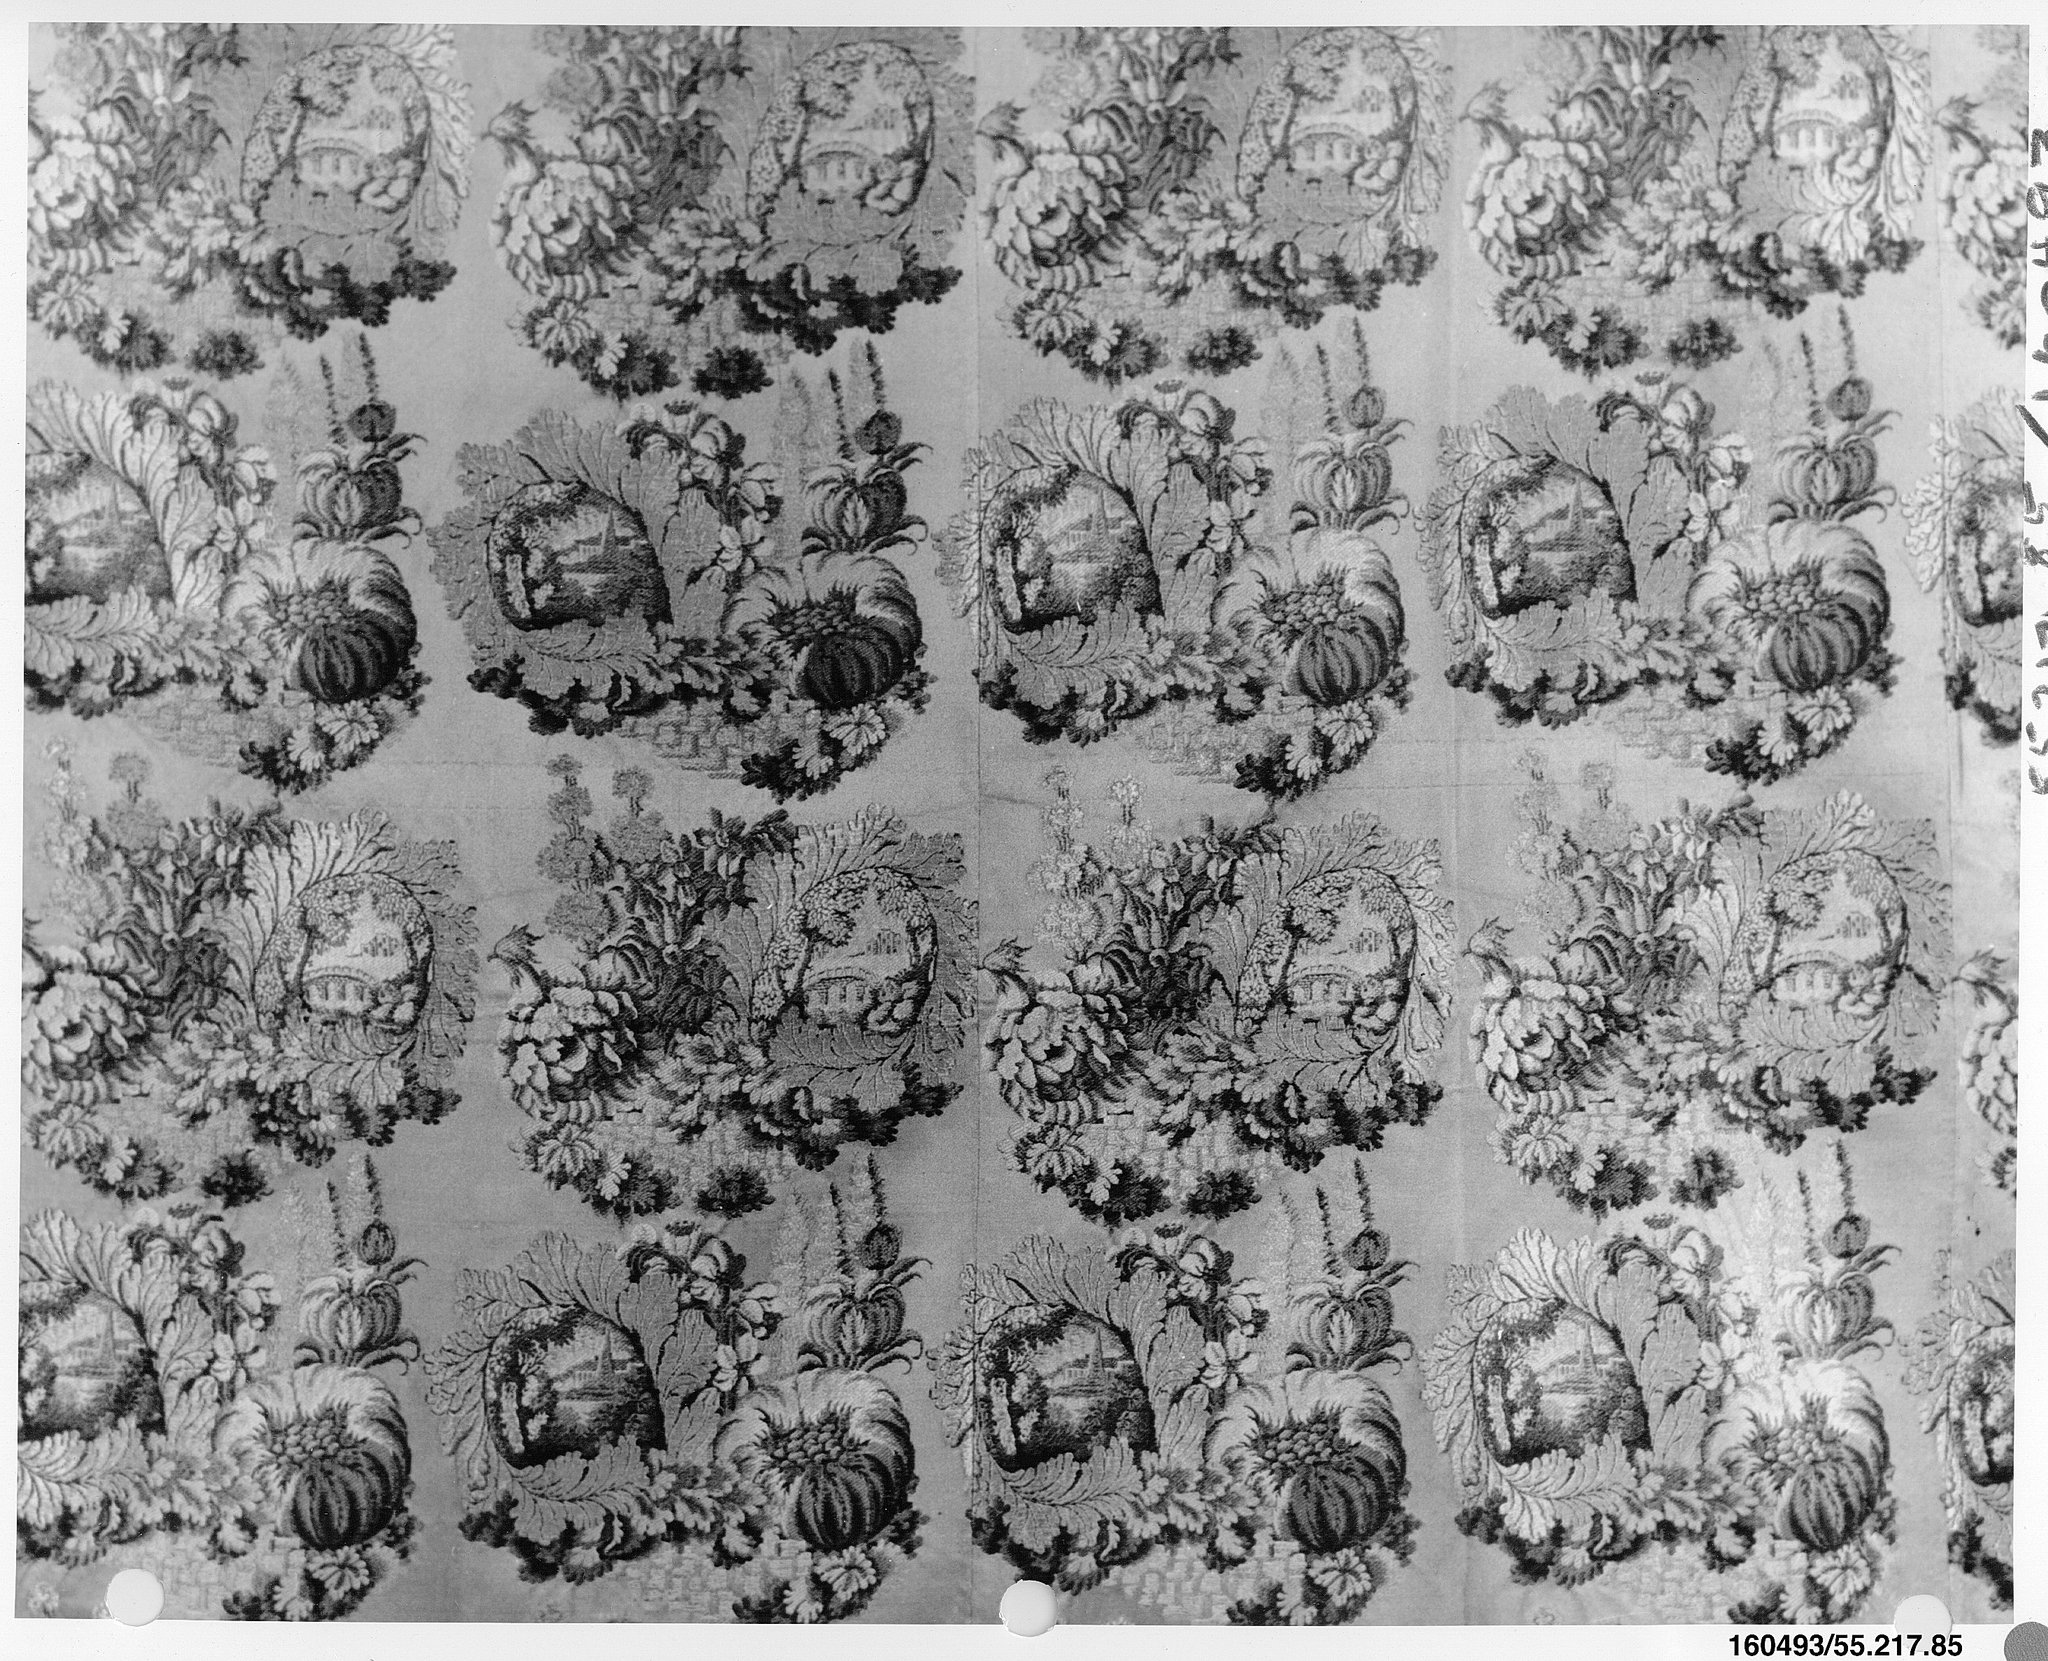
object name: piece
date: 1735-1740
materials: metal thread, silk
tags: flowers